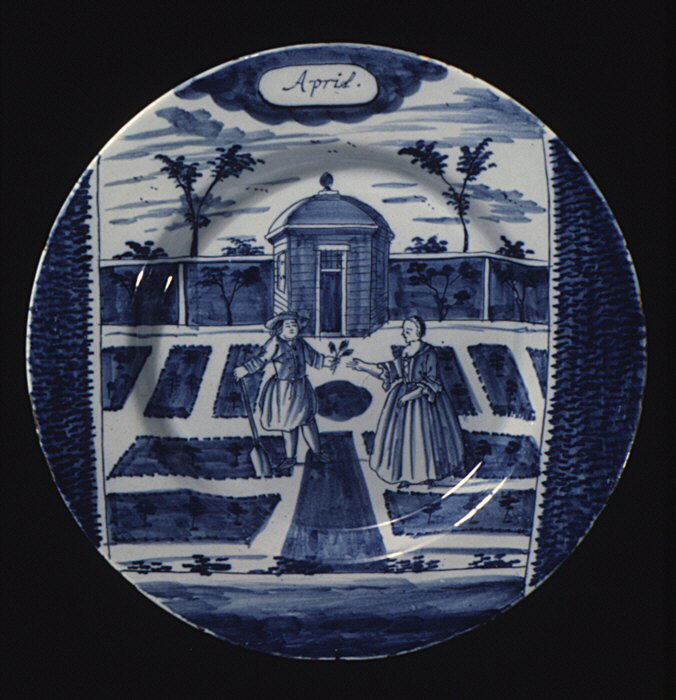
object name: plate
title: Plate (part of a set)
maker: de porceleyne bijl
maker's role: maker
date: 1764-1788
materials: earthenware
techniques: glazing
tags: houses,men,women,trees